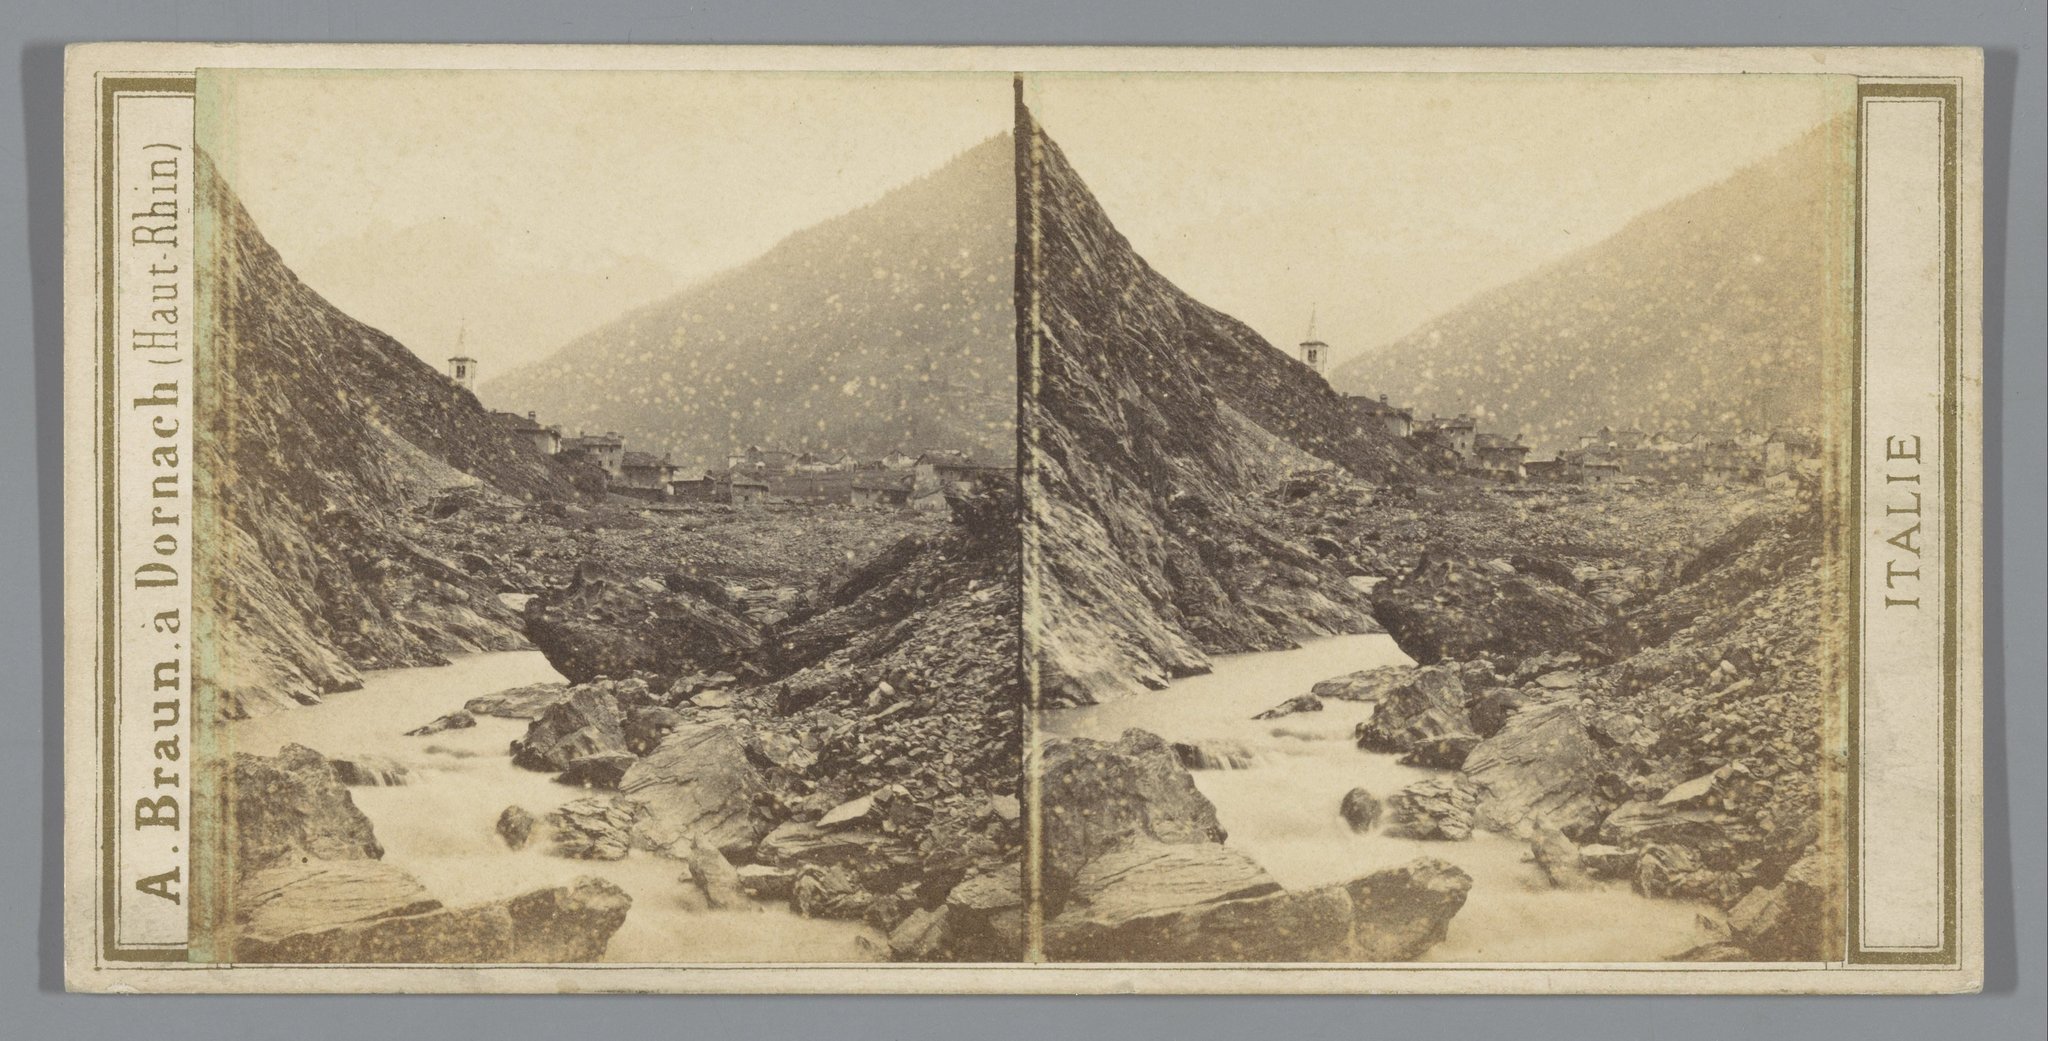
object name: stereograph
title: Vallée d'Aoste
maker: Anonymous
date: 1860-1866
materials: cardboard, paper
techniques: albumen print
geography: dornach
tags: dale, valley, city-view in general; 'veduta'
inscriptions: number: ‘No 2030’